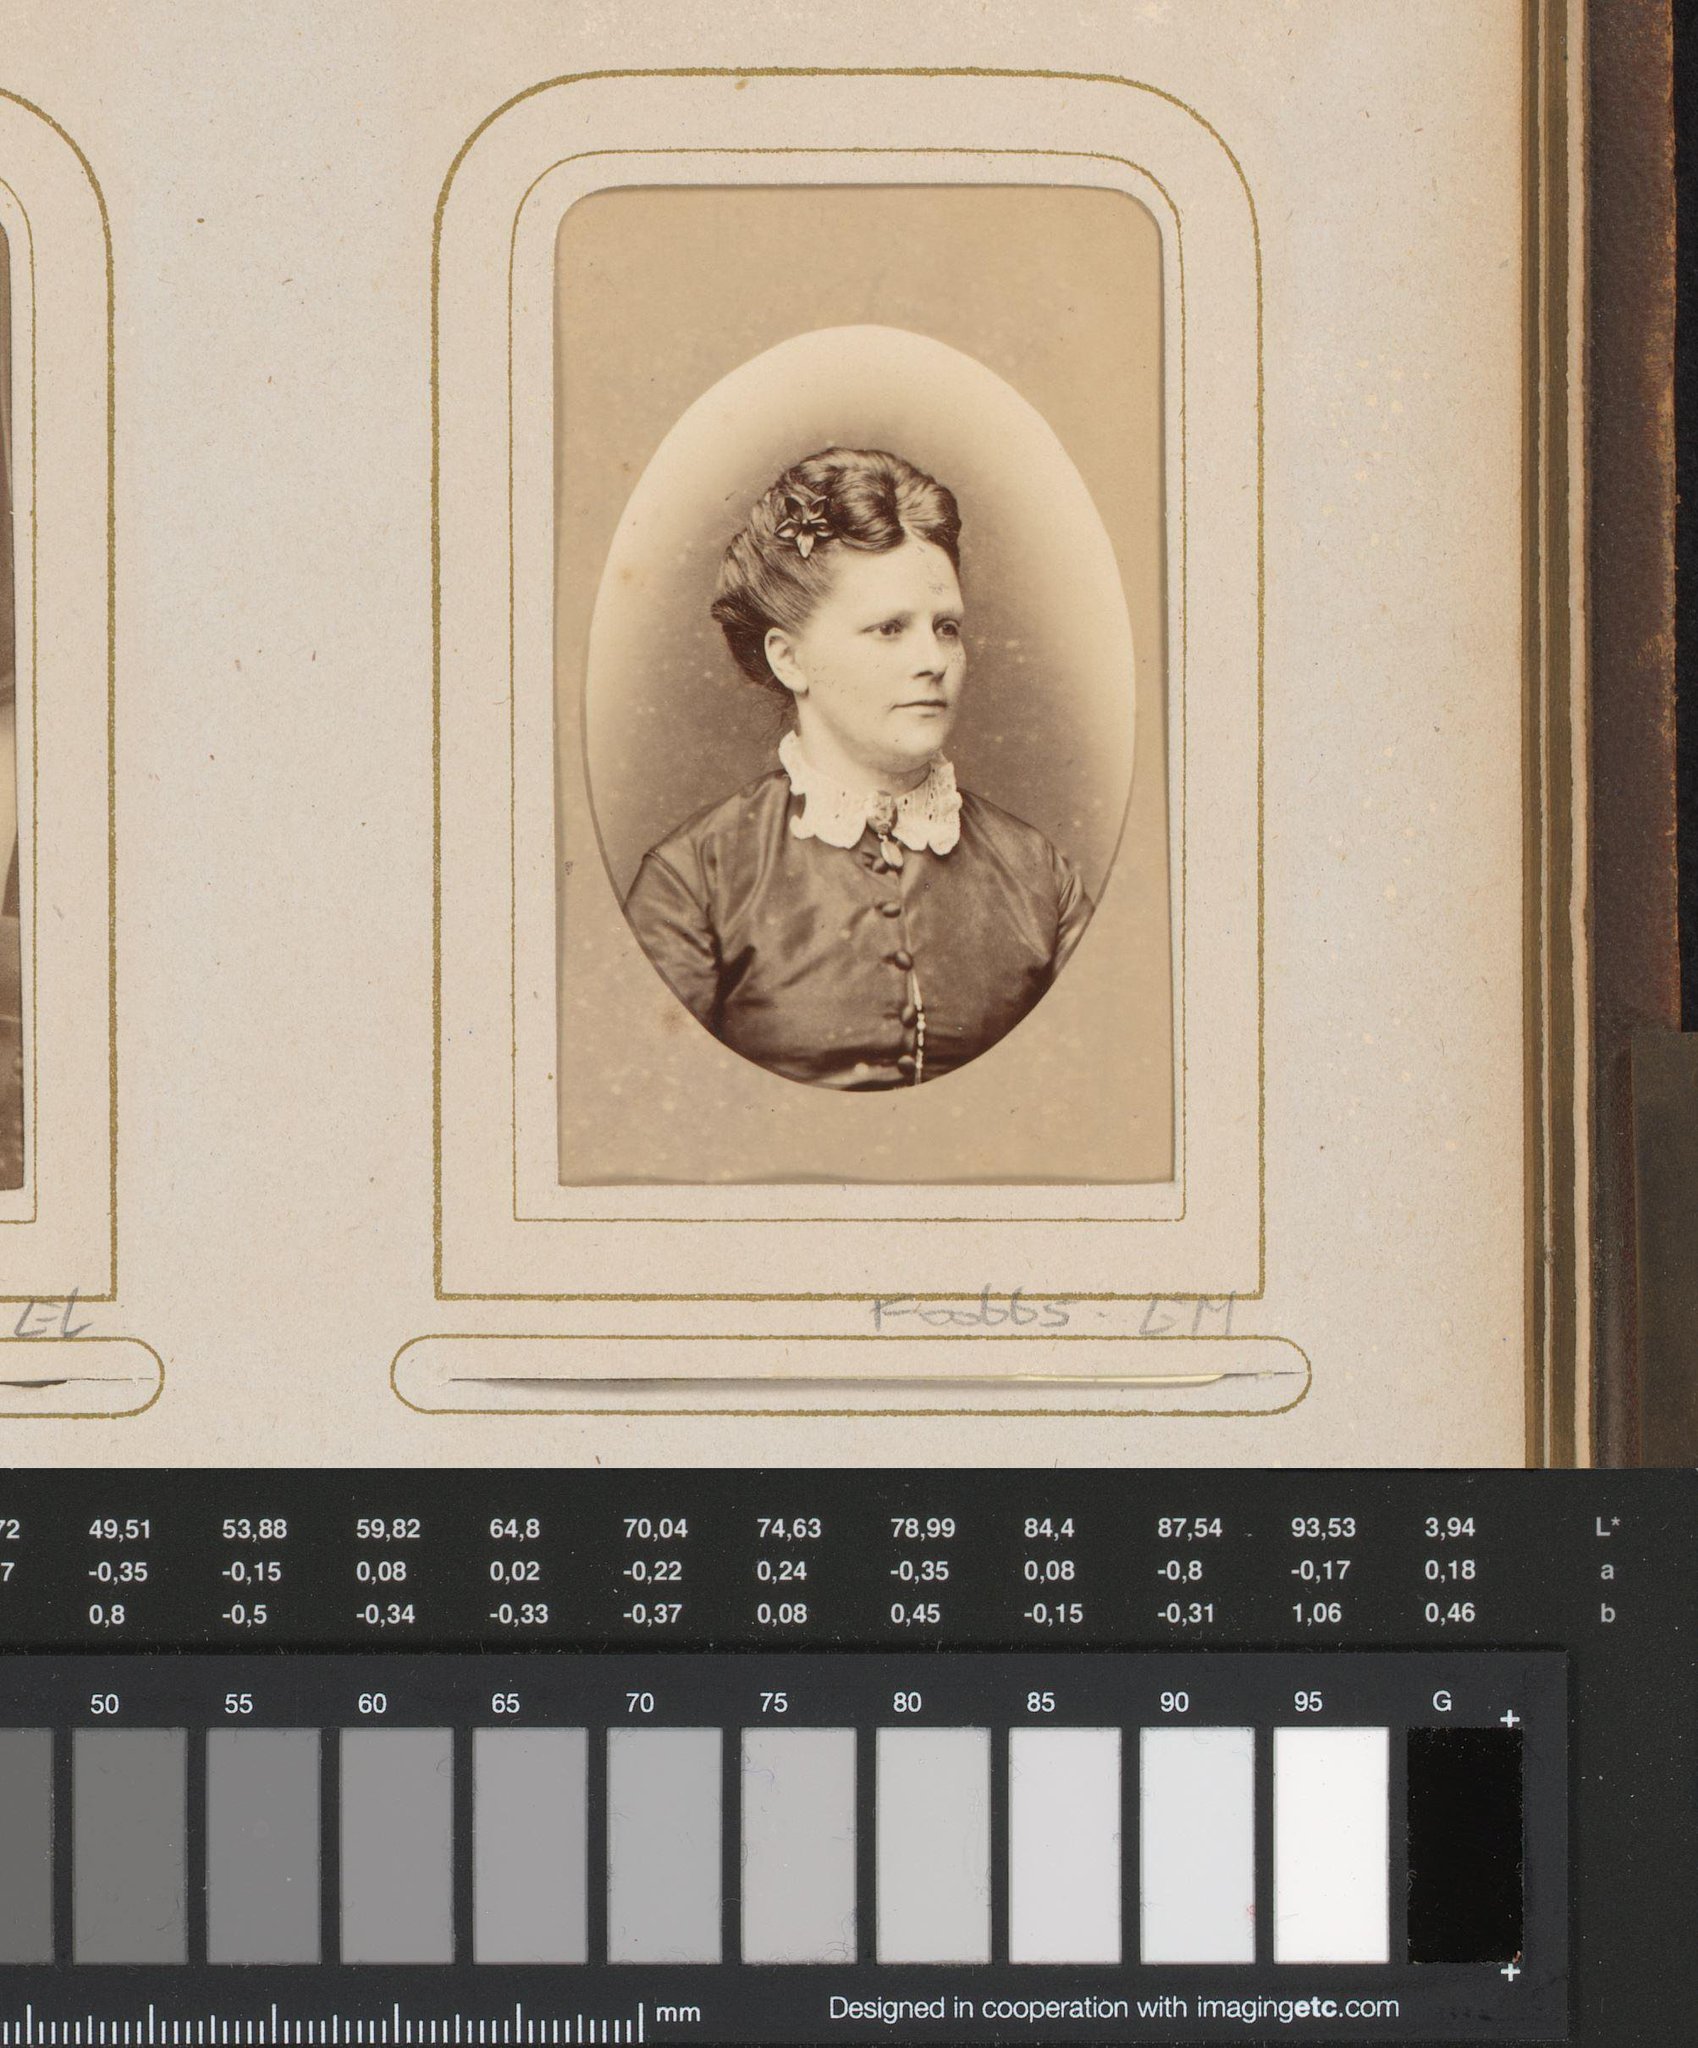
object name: album leaf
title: Portret van een vrouw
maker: cornelis bernardus broersma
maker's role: fotograaf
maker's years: 1841-1919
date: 1874-1890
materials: cardboard, photographic support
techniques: albumen print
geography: leeuwarden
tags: historical persons - bb - woman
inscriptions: inscription: ‘C.B. Broersma/ Photographische kunstinrichting/ Vleeschmarkt/ Letter E no.8/ Leeuwarden’